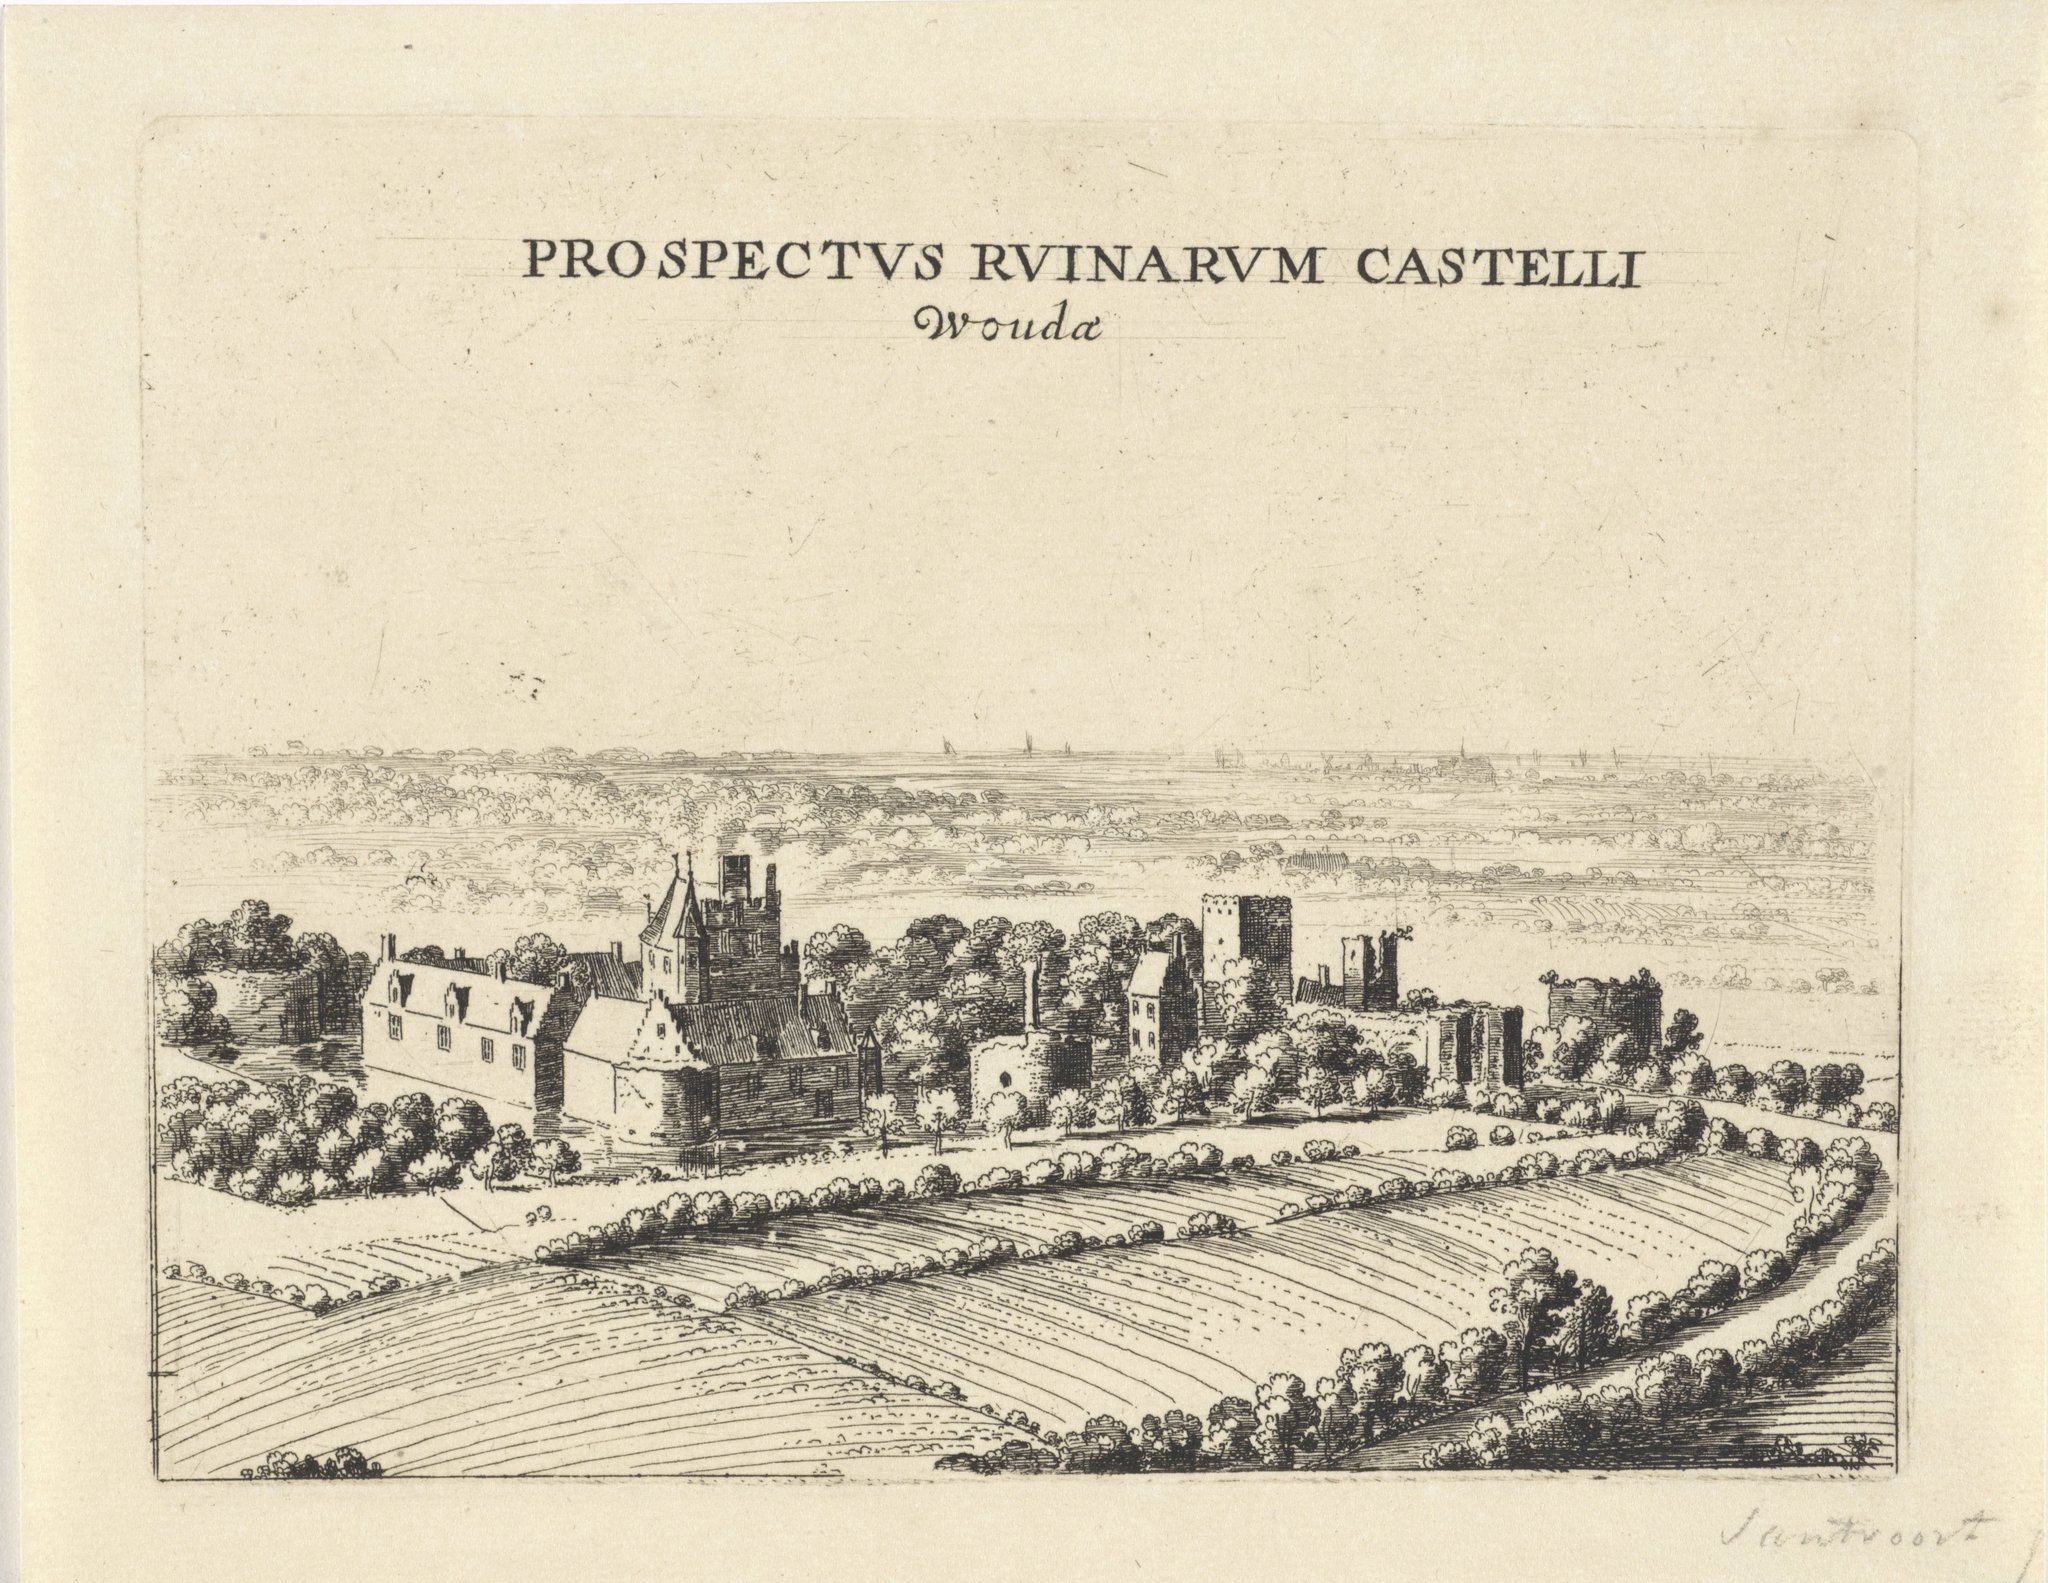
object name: print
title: Gezicht op Kasteel van Woude bij Ridderkerk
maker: abraham dircksz. santvoort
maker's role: print maker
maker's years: 1614-1669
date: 1640-1669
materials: paper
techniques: etching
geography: netherlands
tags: landscape with ruins (+ city(-scape) with figures, staffage), ruin of a dwelling, house, castle, etc.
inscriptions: collector's mark: Lugt 2228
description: Gezicht op Kasteel van Woude bij Ridderkerk in vogelperspectief. Het kasteel wordt door een gracht en landbouwgrond omgeven.